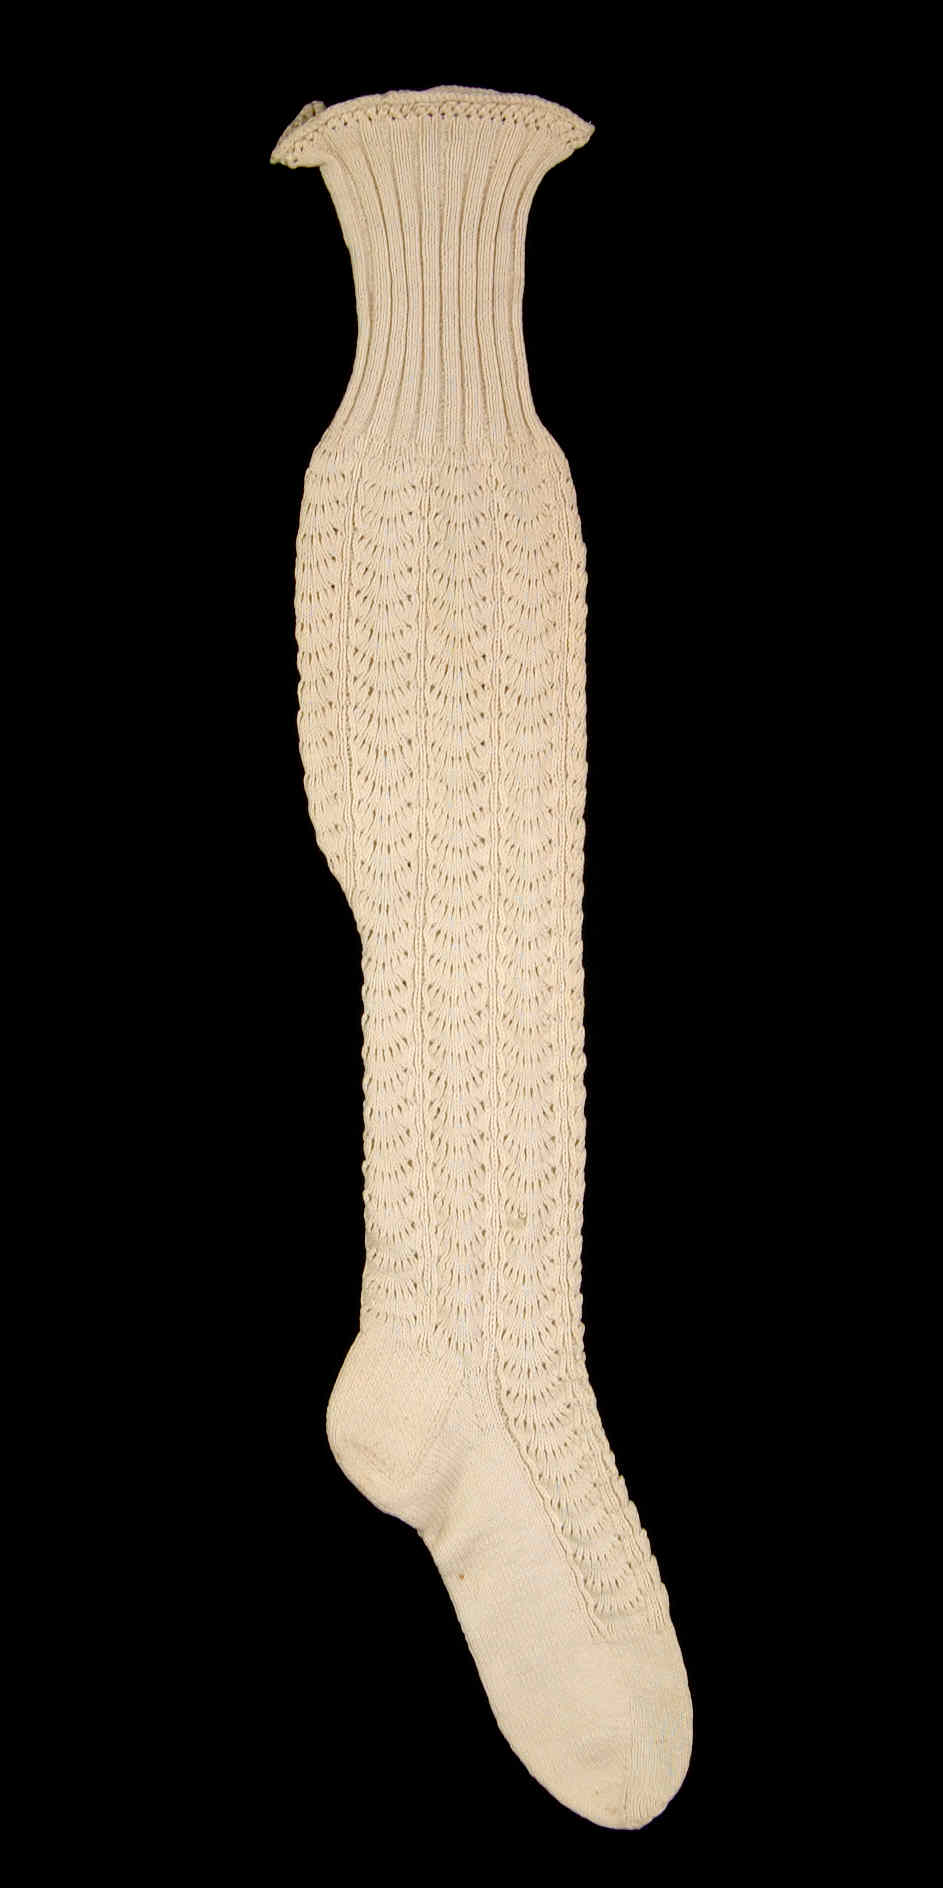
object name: stocking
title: Stockings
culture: american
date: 1873-1877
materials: cotton